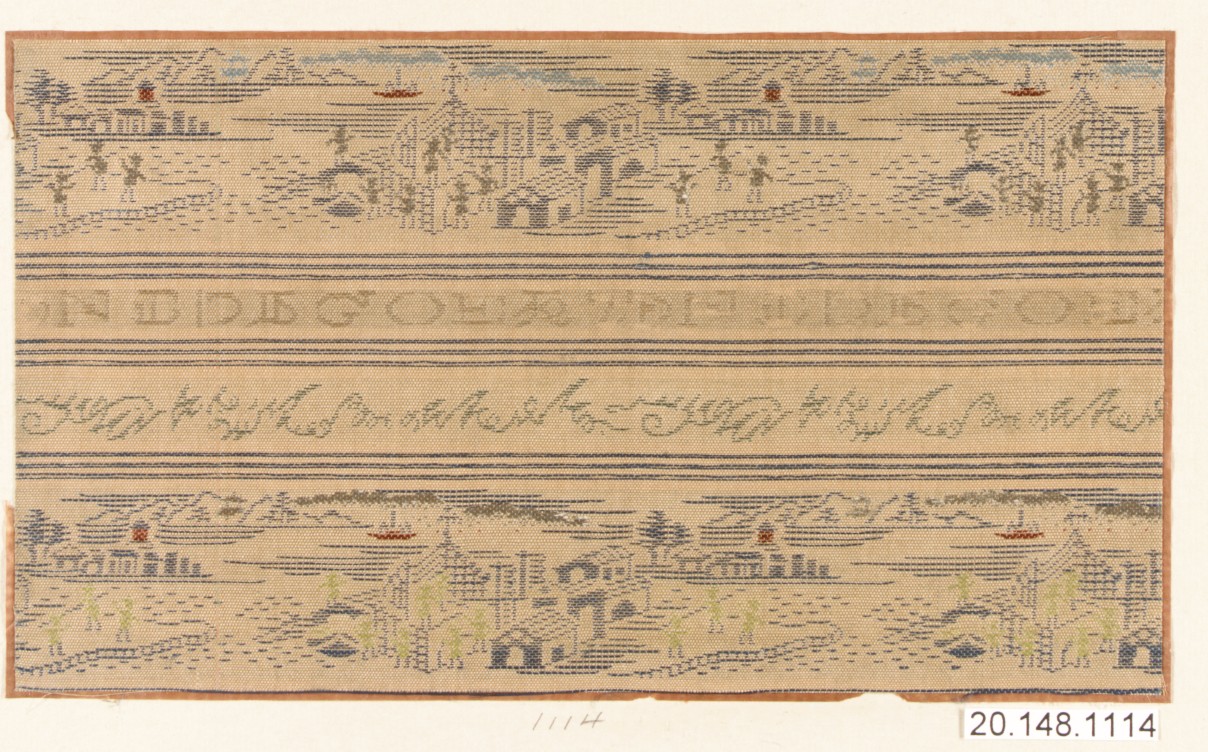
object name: piece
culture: japanese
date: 1701-1800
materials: silk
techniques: compound weave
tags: buildings